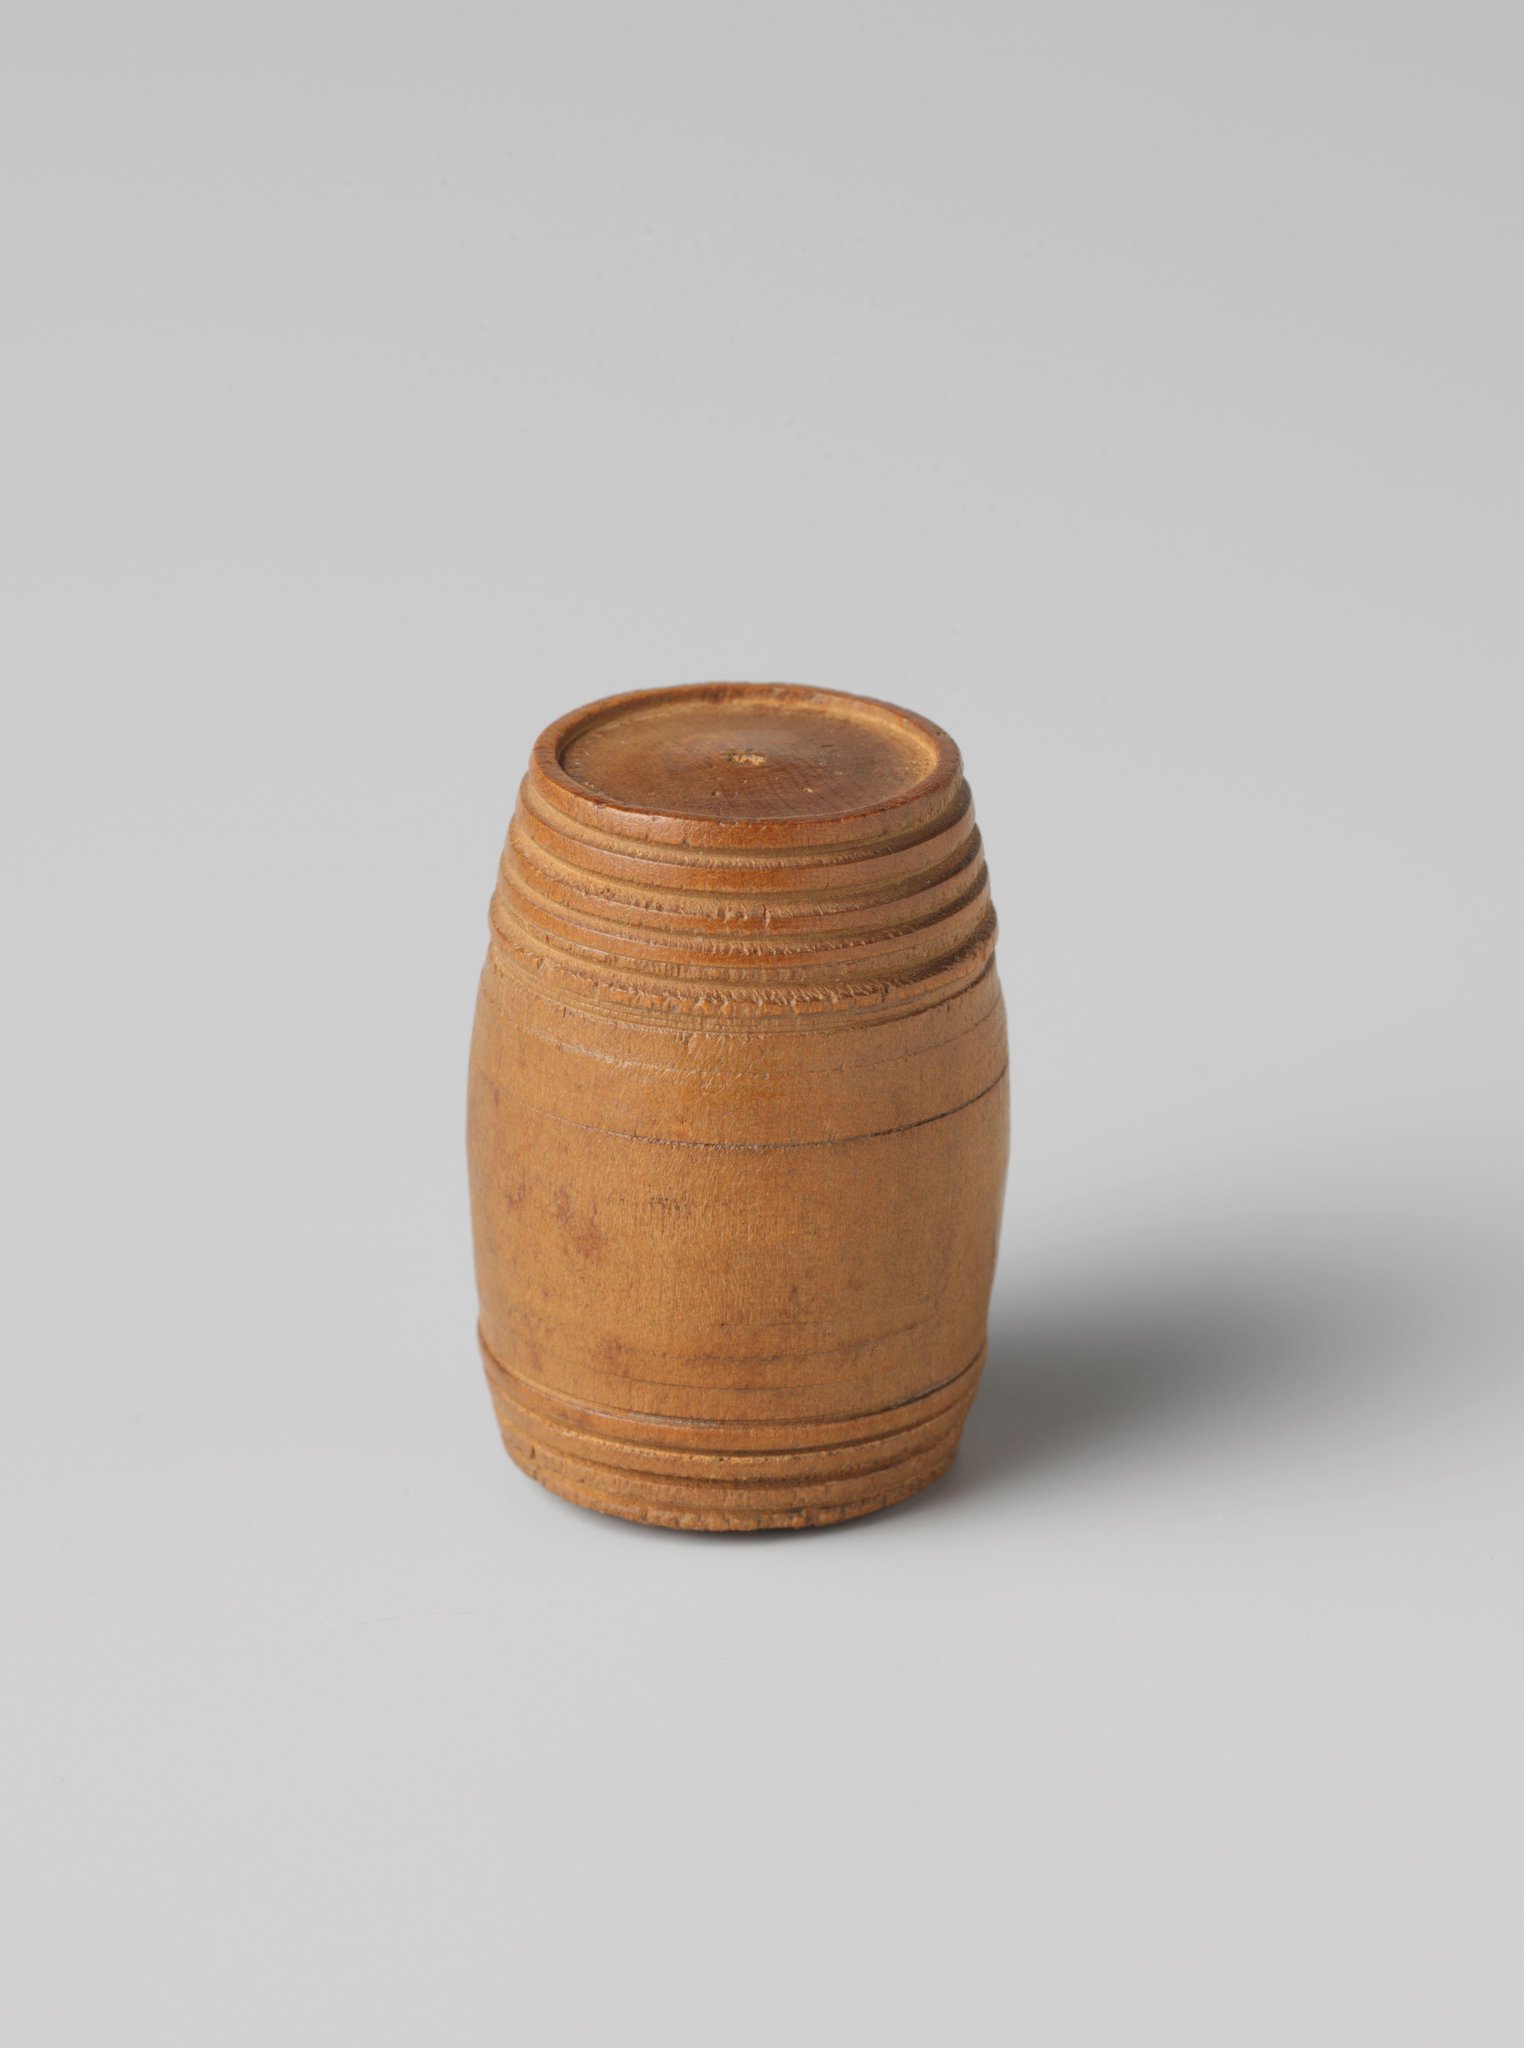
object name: miniature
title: Vat van gedraaid, massief hout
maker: Anonymous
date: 1700-1799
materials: wood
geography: amsterdam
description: Een vat gedraaid van massief esdoornhout.